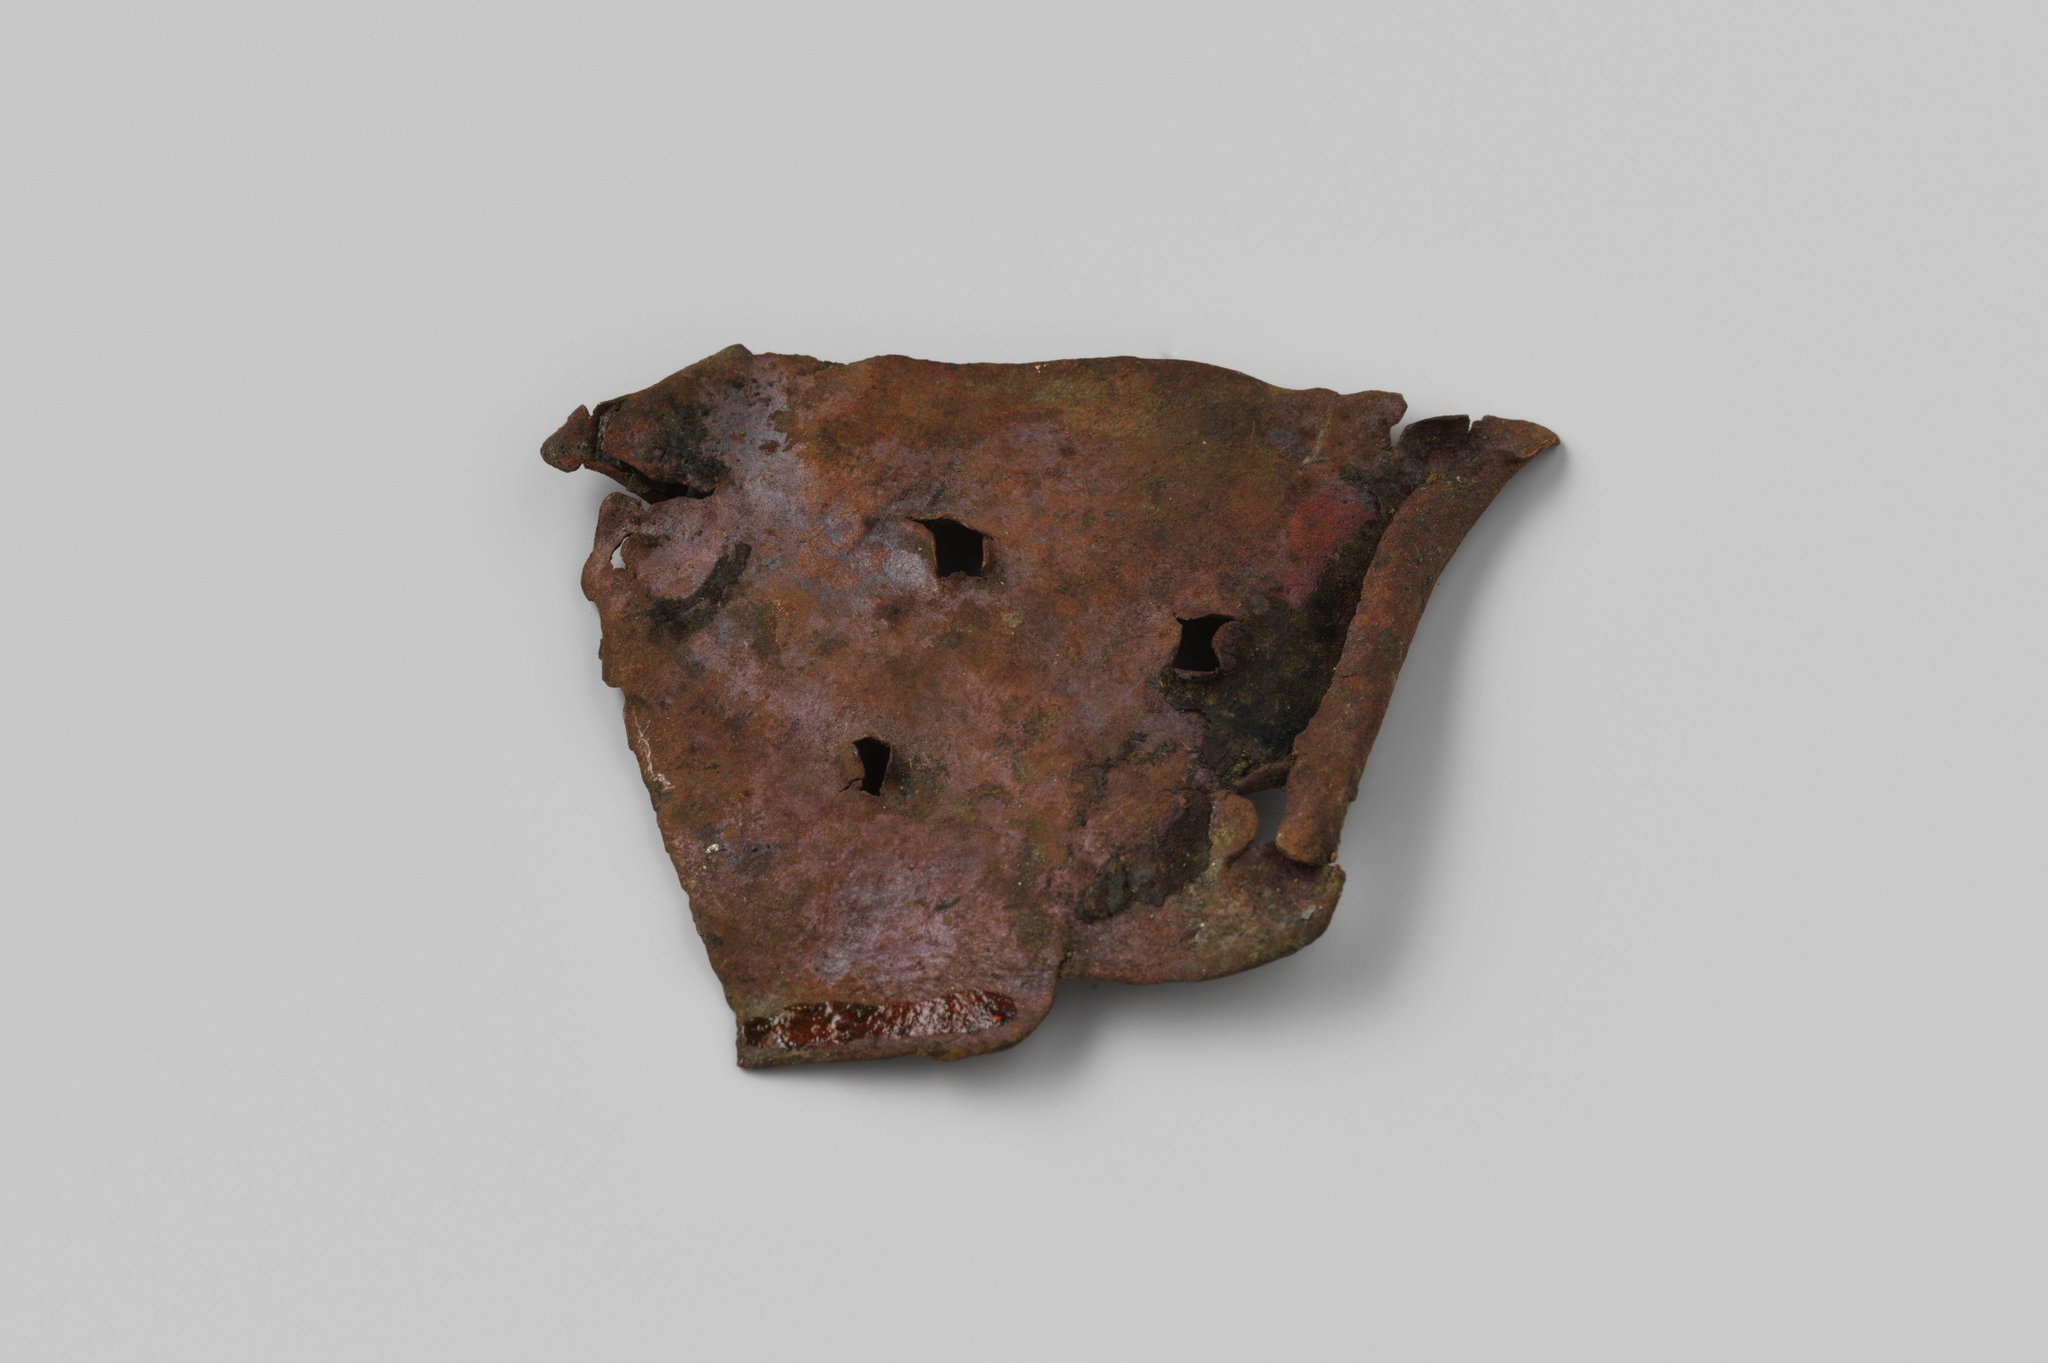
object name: fragment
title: Fragment uit het wrak van de Oost-Indiëvaarder Hollandia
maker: Anonymous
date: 1700-1743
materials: copper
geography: netherlands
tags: verenigde oostindische compagnie, hollandia (schip), annet